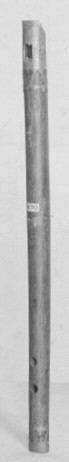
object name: tabor pipe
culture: french or teneriffe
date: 1701-1800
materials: pewter, wood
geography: spain